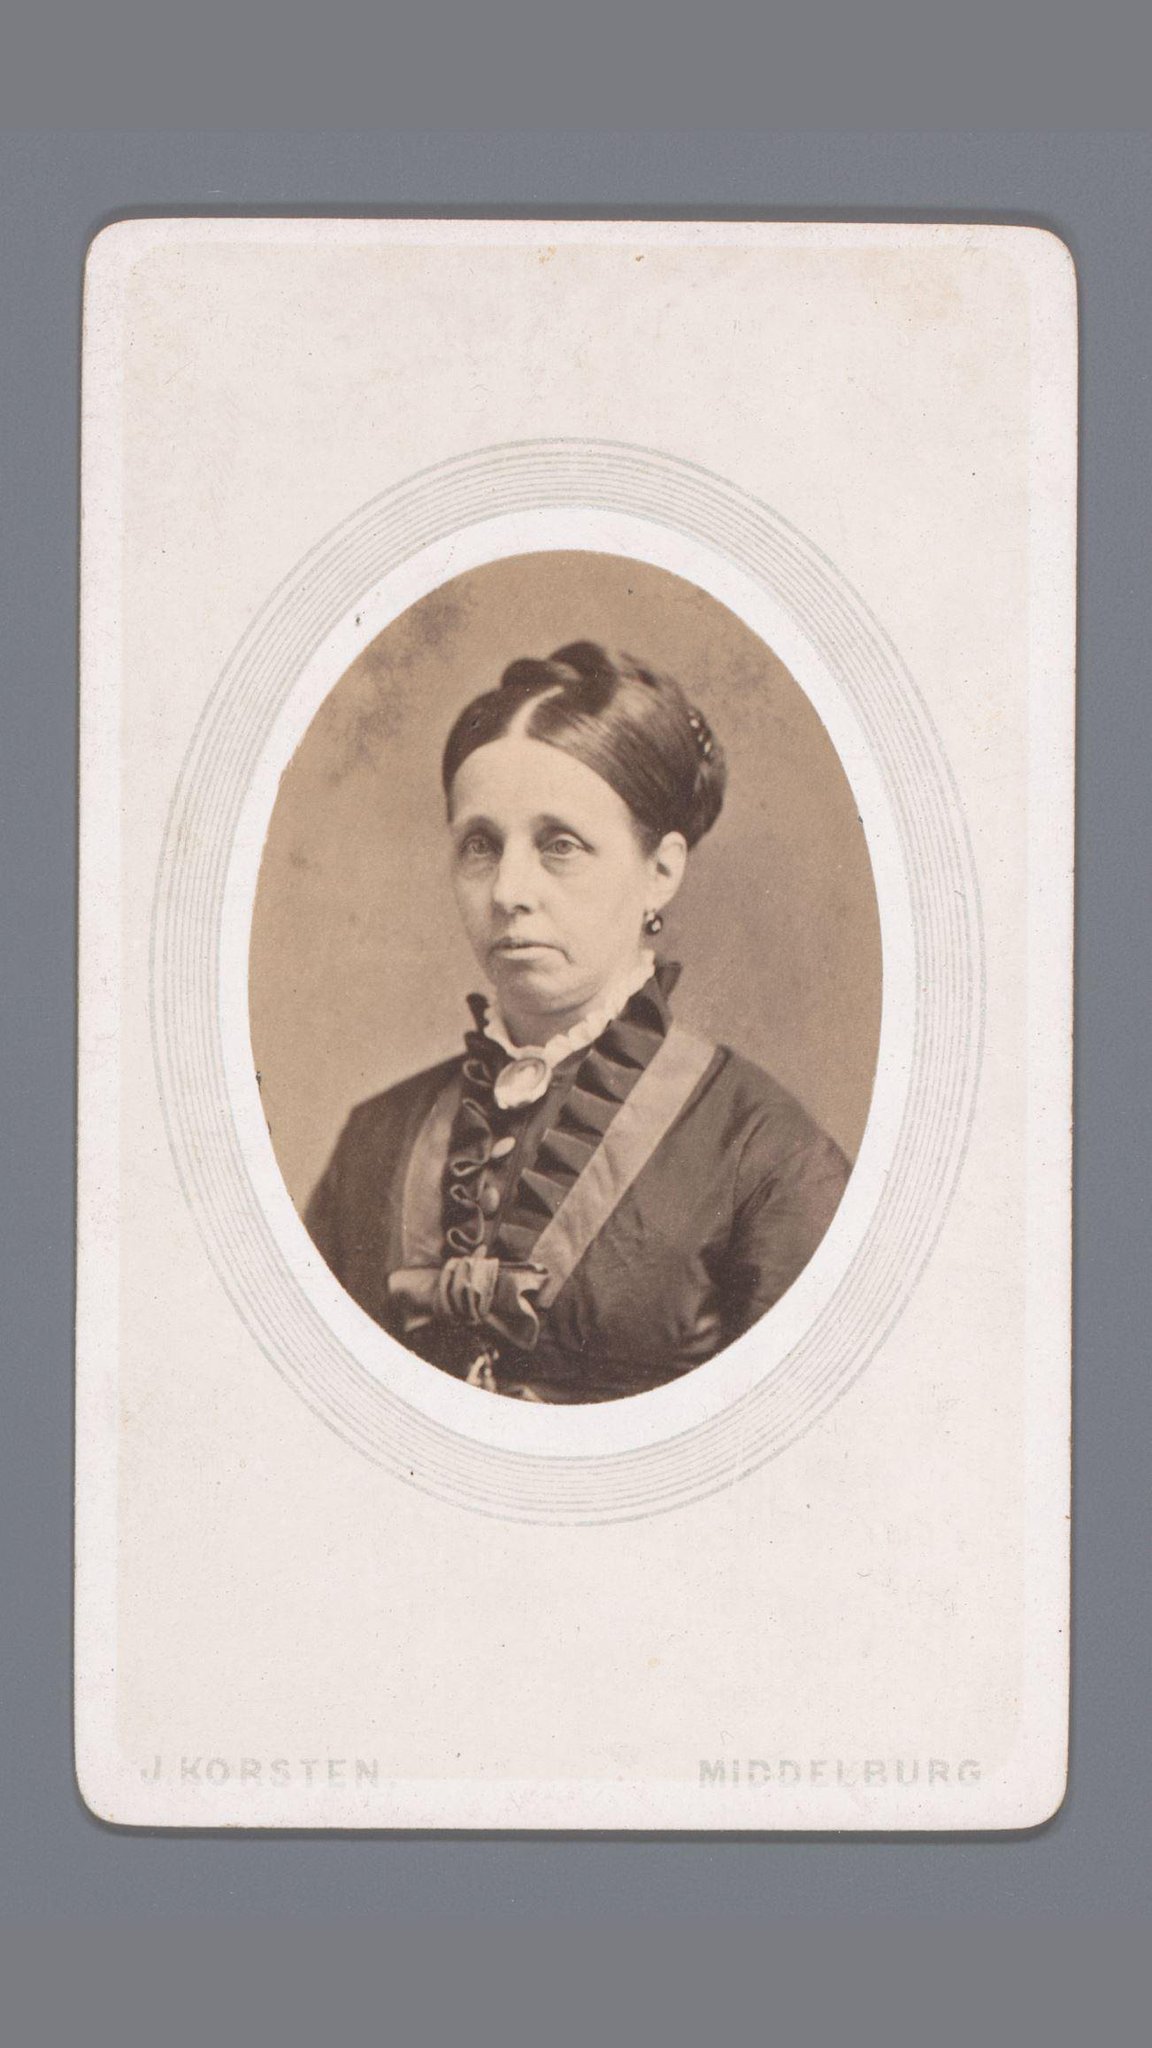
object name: carte de visite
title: Portret van een onbekende vrouw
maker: j. korsten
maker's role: fotograaf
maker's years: 1841-1878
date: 1864-1872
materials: cardboard, paper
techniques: albumen print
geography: middelburg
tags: historical persons - bb - woman